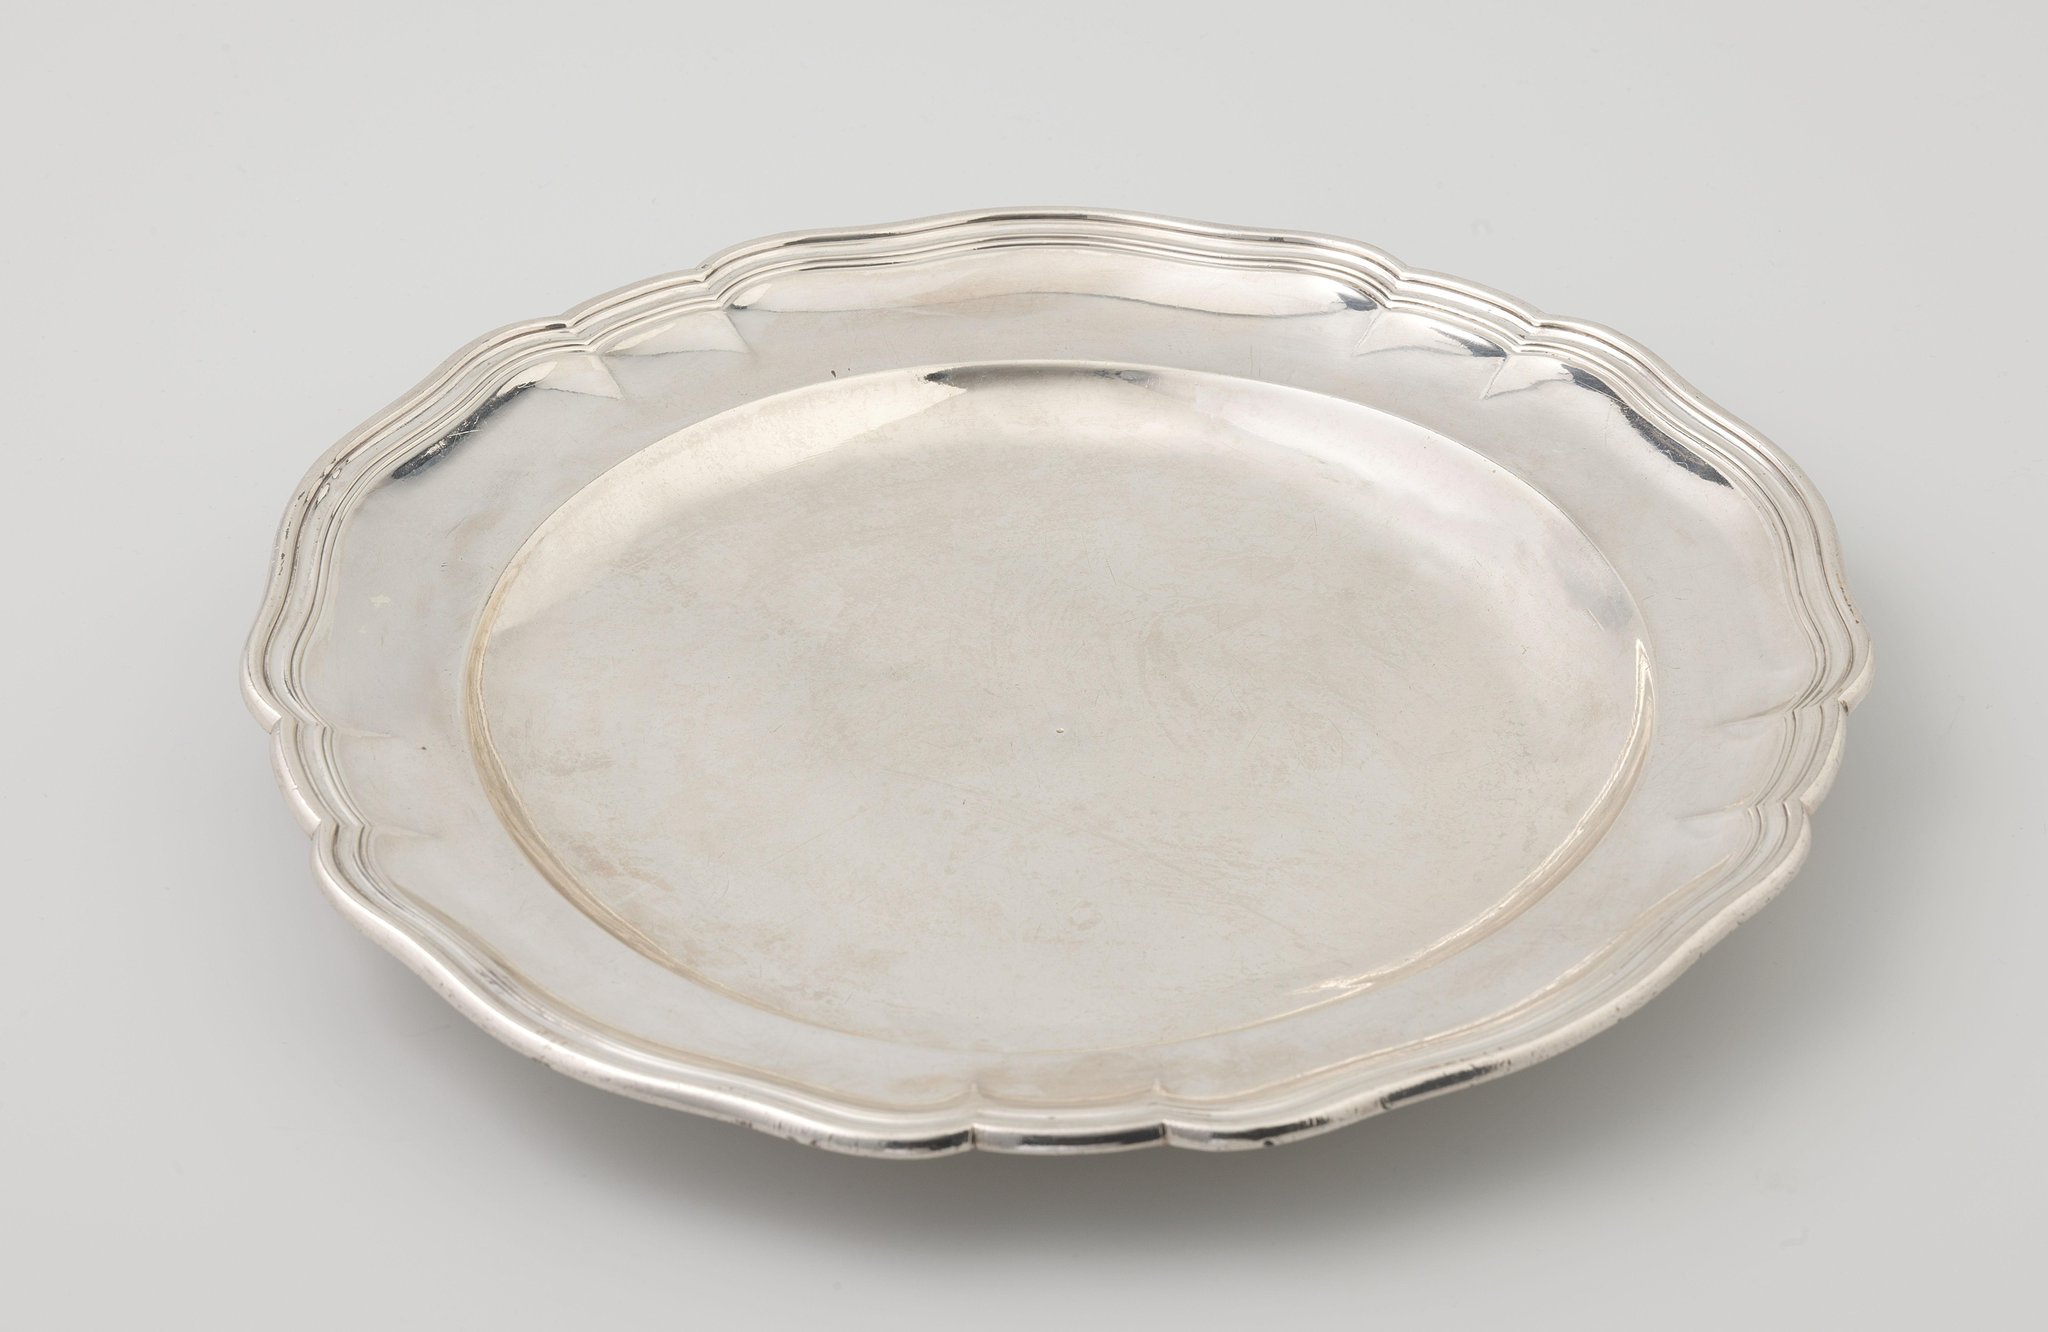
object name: platter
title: Schotel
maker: Anonymous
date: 1700-1715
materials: silver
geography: leningrad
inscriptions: mark, number: ‘N 24, 24’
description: Ronde schotel van zilver. Omgeven door een zesmaal ingetrokken, gegolfde filet-rand. Gegraveerd met de Russische dubbele adelaar. Gemerkt: H.M.